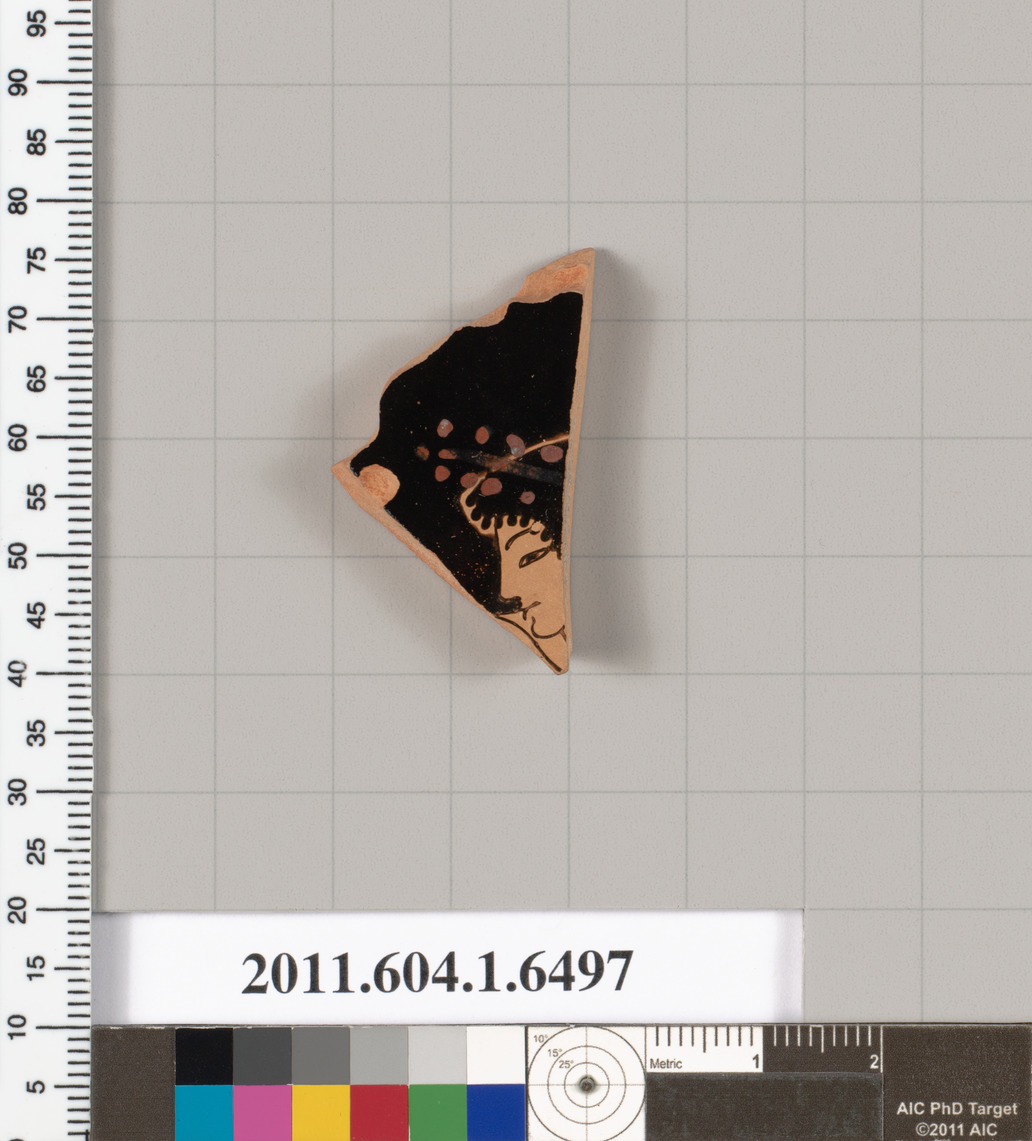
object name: kylix fragment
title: Terracotta fragment of a kylix (drinking cup)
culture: greek, attic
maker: colmar painter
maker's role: artist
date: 490-480 BCE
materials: terracotta